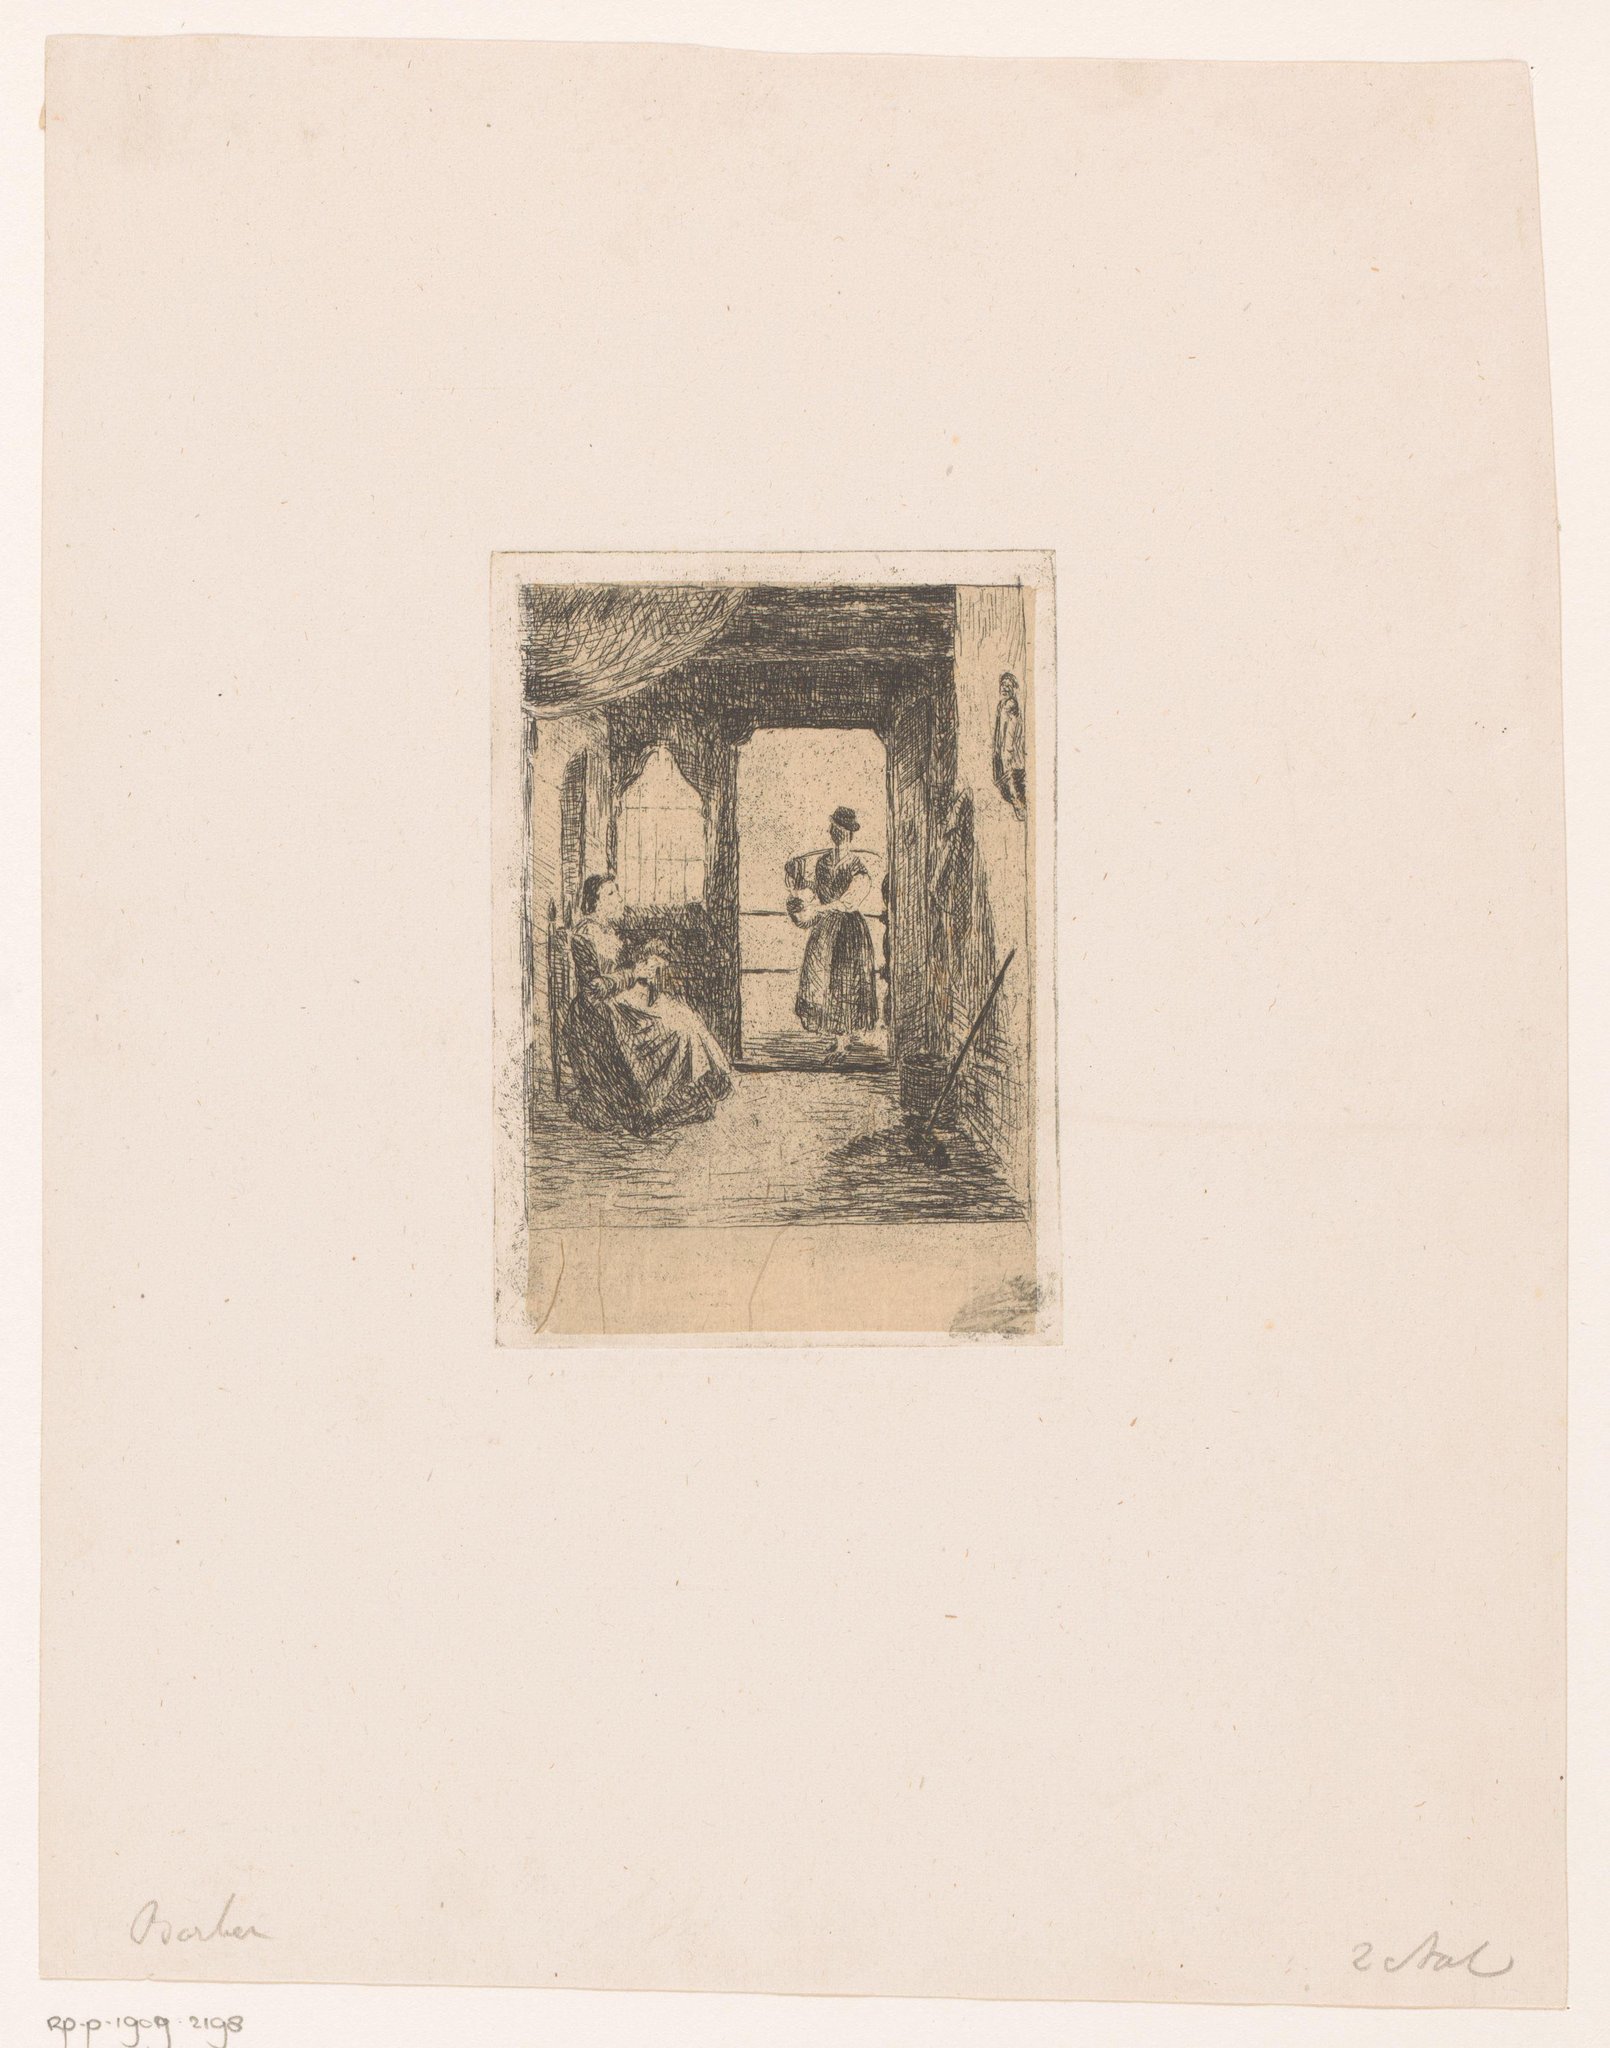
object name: print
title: Melkmeisje brengt een kan bij een dame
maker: w.f. barber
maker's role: print maker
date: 1850-1909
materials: paper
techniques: etching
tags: milkmaid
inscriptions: collector's mark: Lugt 2228, annotation: ‘5 la femme assise interieur’, annotation: ‘2 etat’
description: Sterfdatum kunstenaar onbekend. Derhalve is voor bepaling van de rechten van dit object de verwervingsdatum aangehouden.